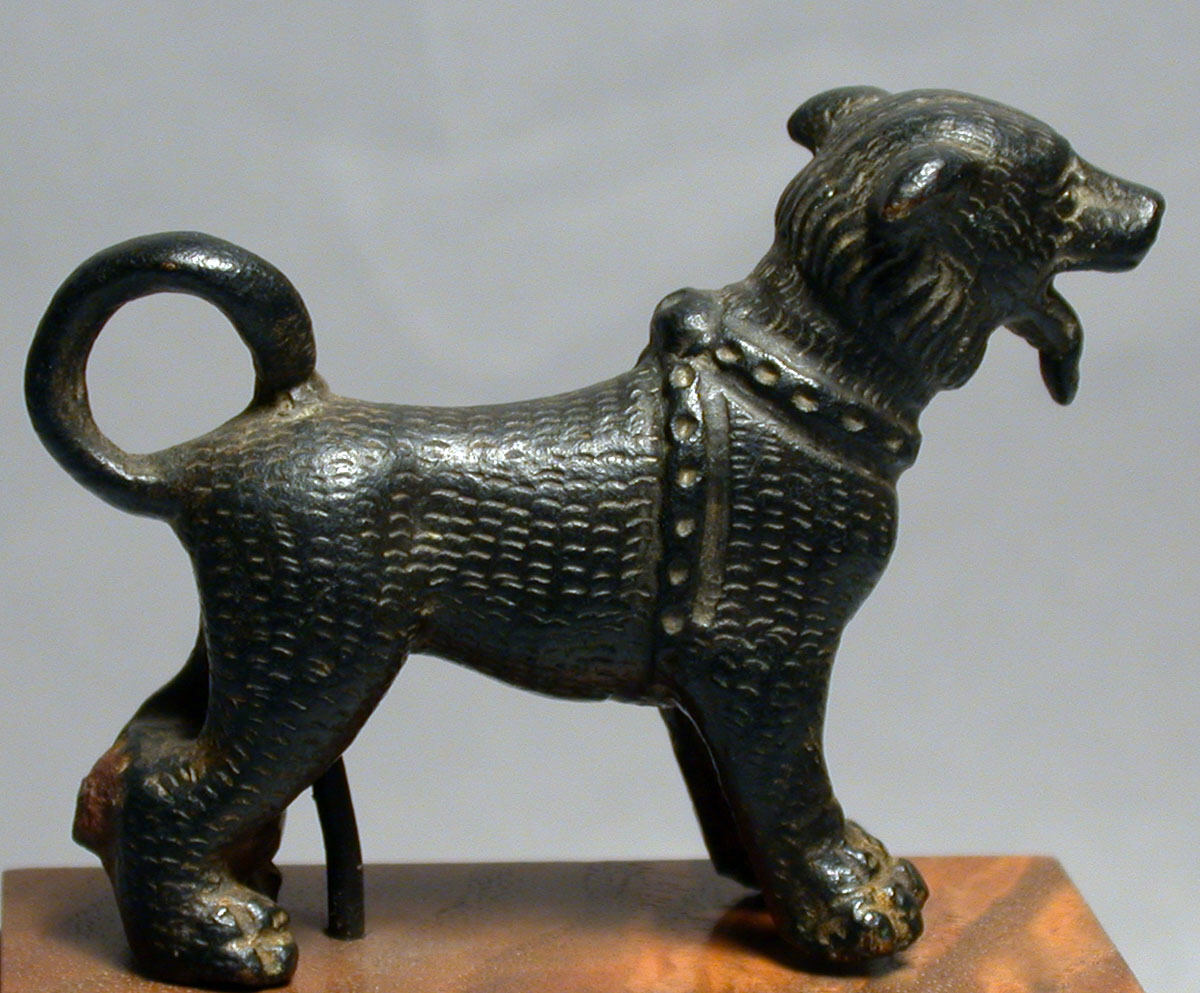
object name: dog figure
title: Bronze figure of a dog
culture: roman, asia minor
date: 1-200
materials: bronze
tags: dogs